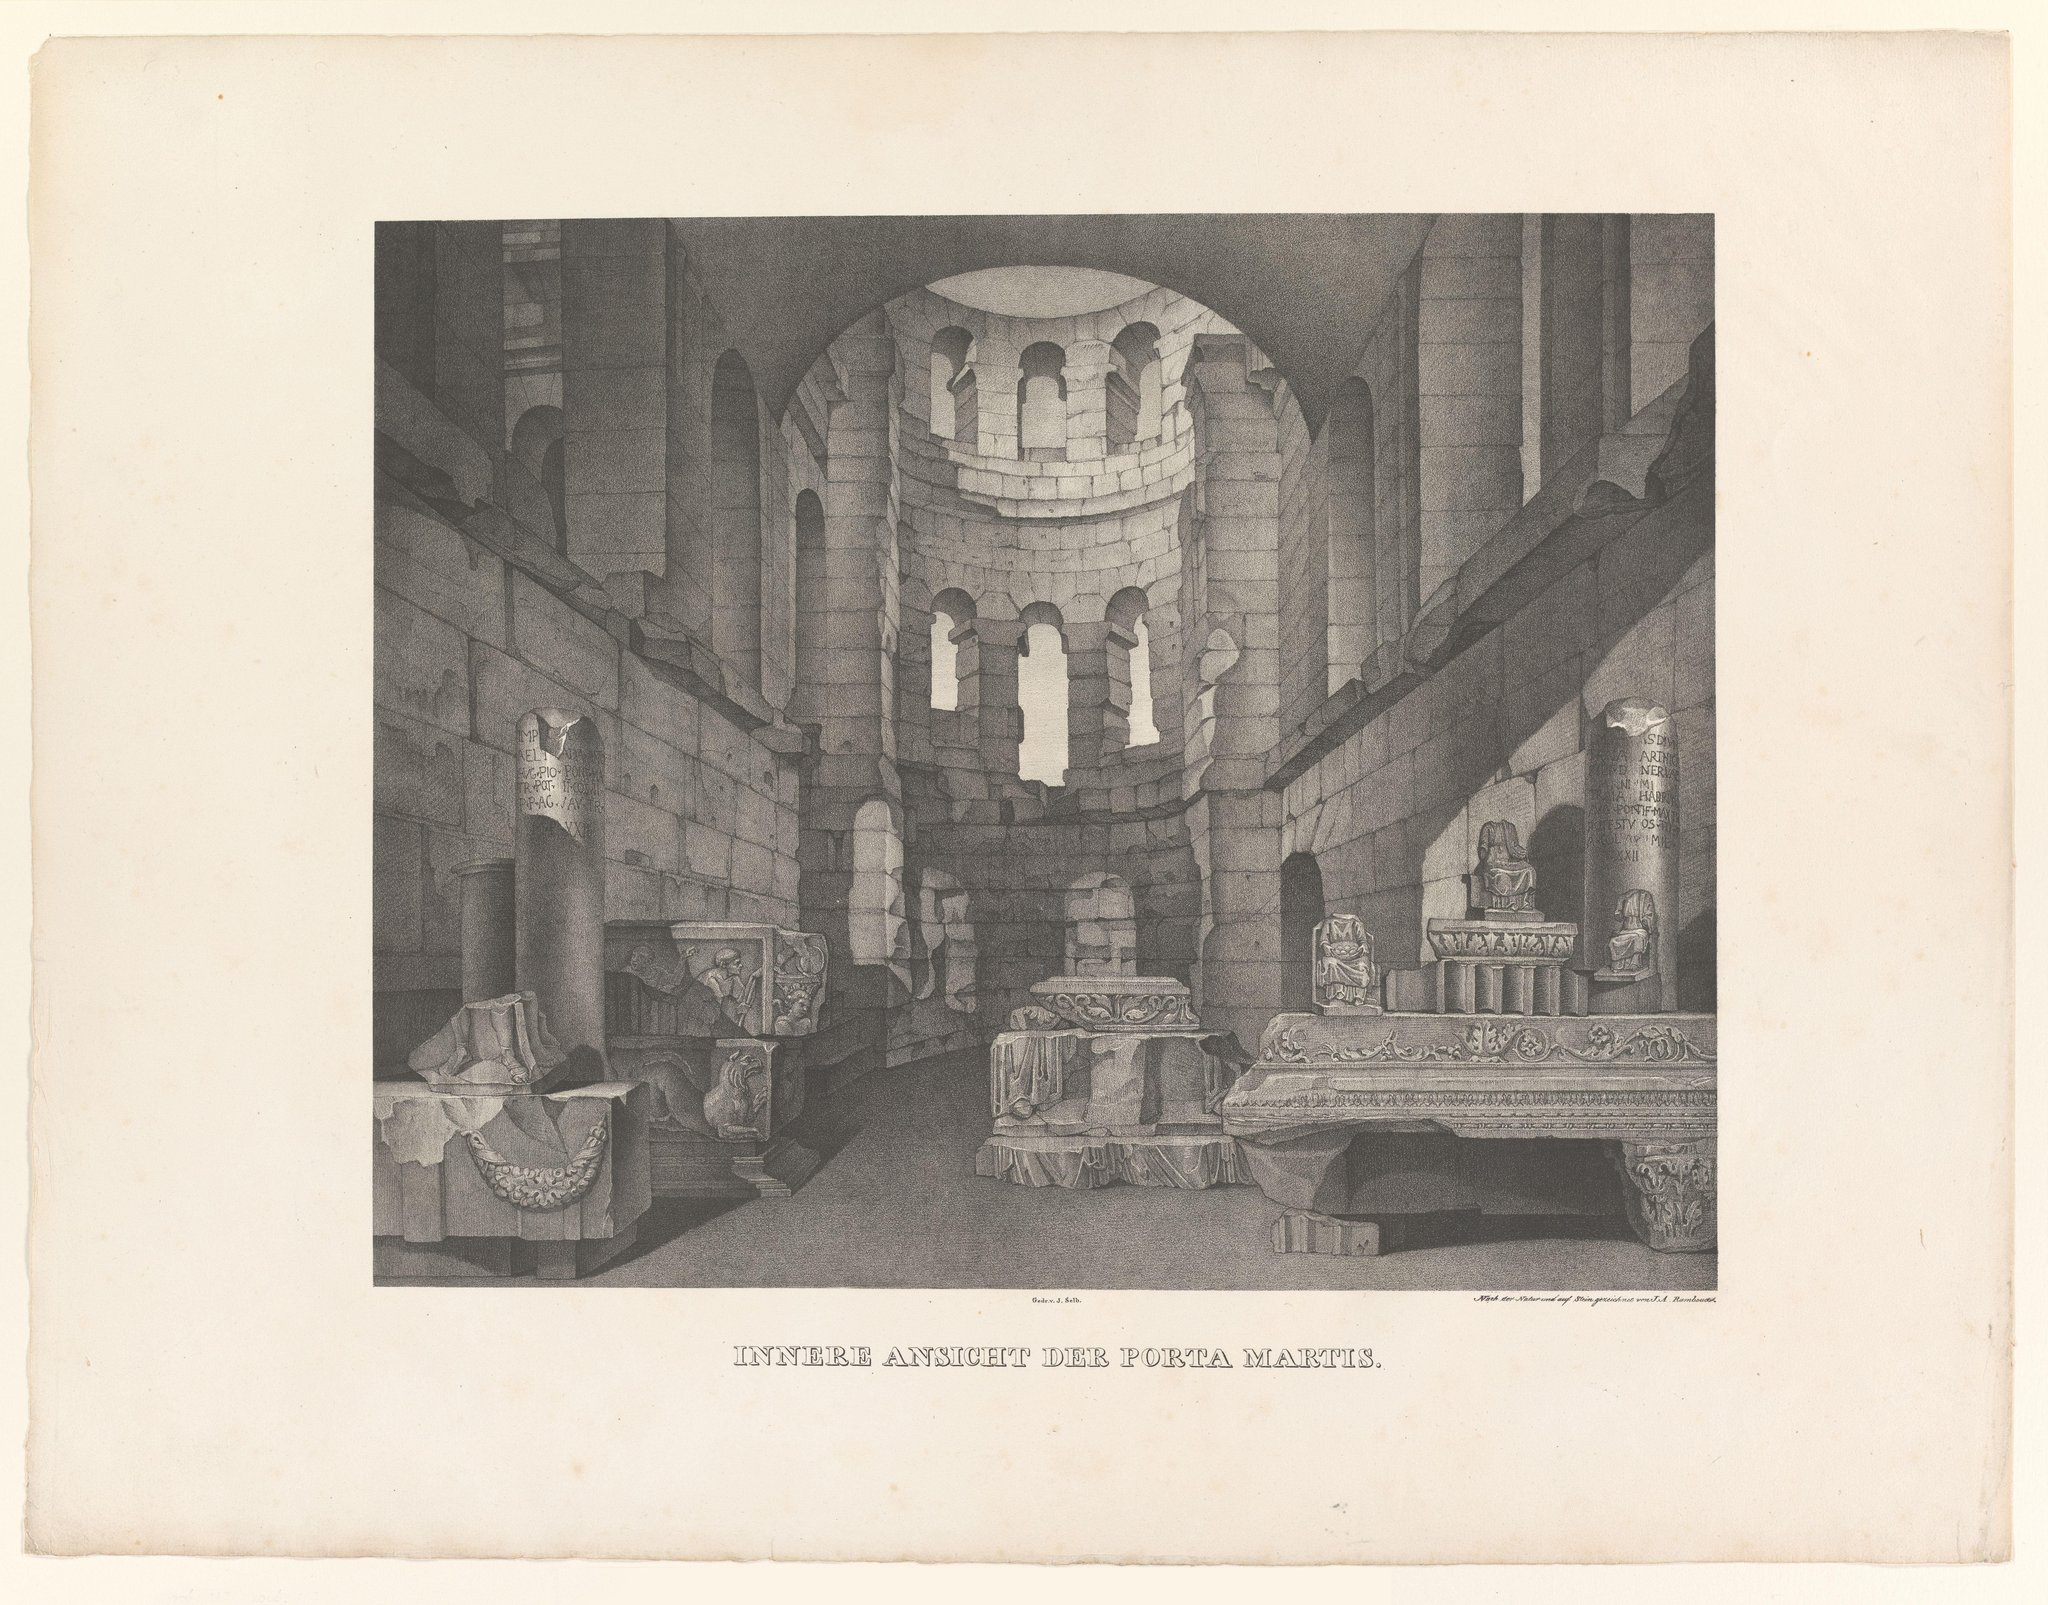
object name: print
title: Gezichten op oudheden en natuur in de omgeving van Trier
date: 1824-1827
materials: paper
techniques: lithograph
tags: ruin of a building ~ architecture, gate, entrance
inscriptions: collector's mark: Lugt 2760, collector's mark: Lugt 2228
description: Prent behoort tot de serie 'Malerische Ansichten der werkwürdigsten Alterthümer und vorzüglicher Naturanlagen im Moselthale bey Trier', verschenen in de periode 1824-1827.